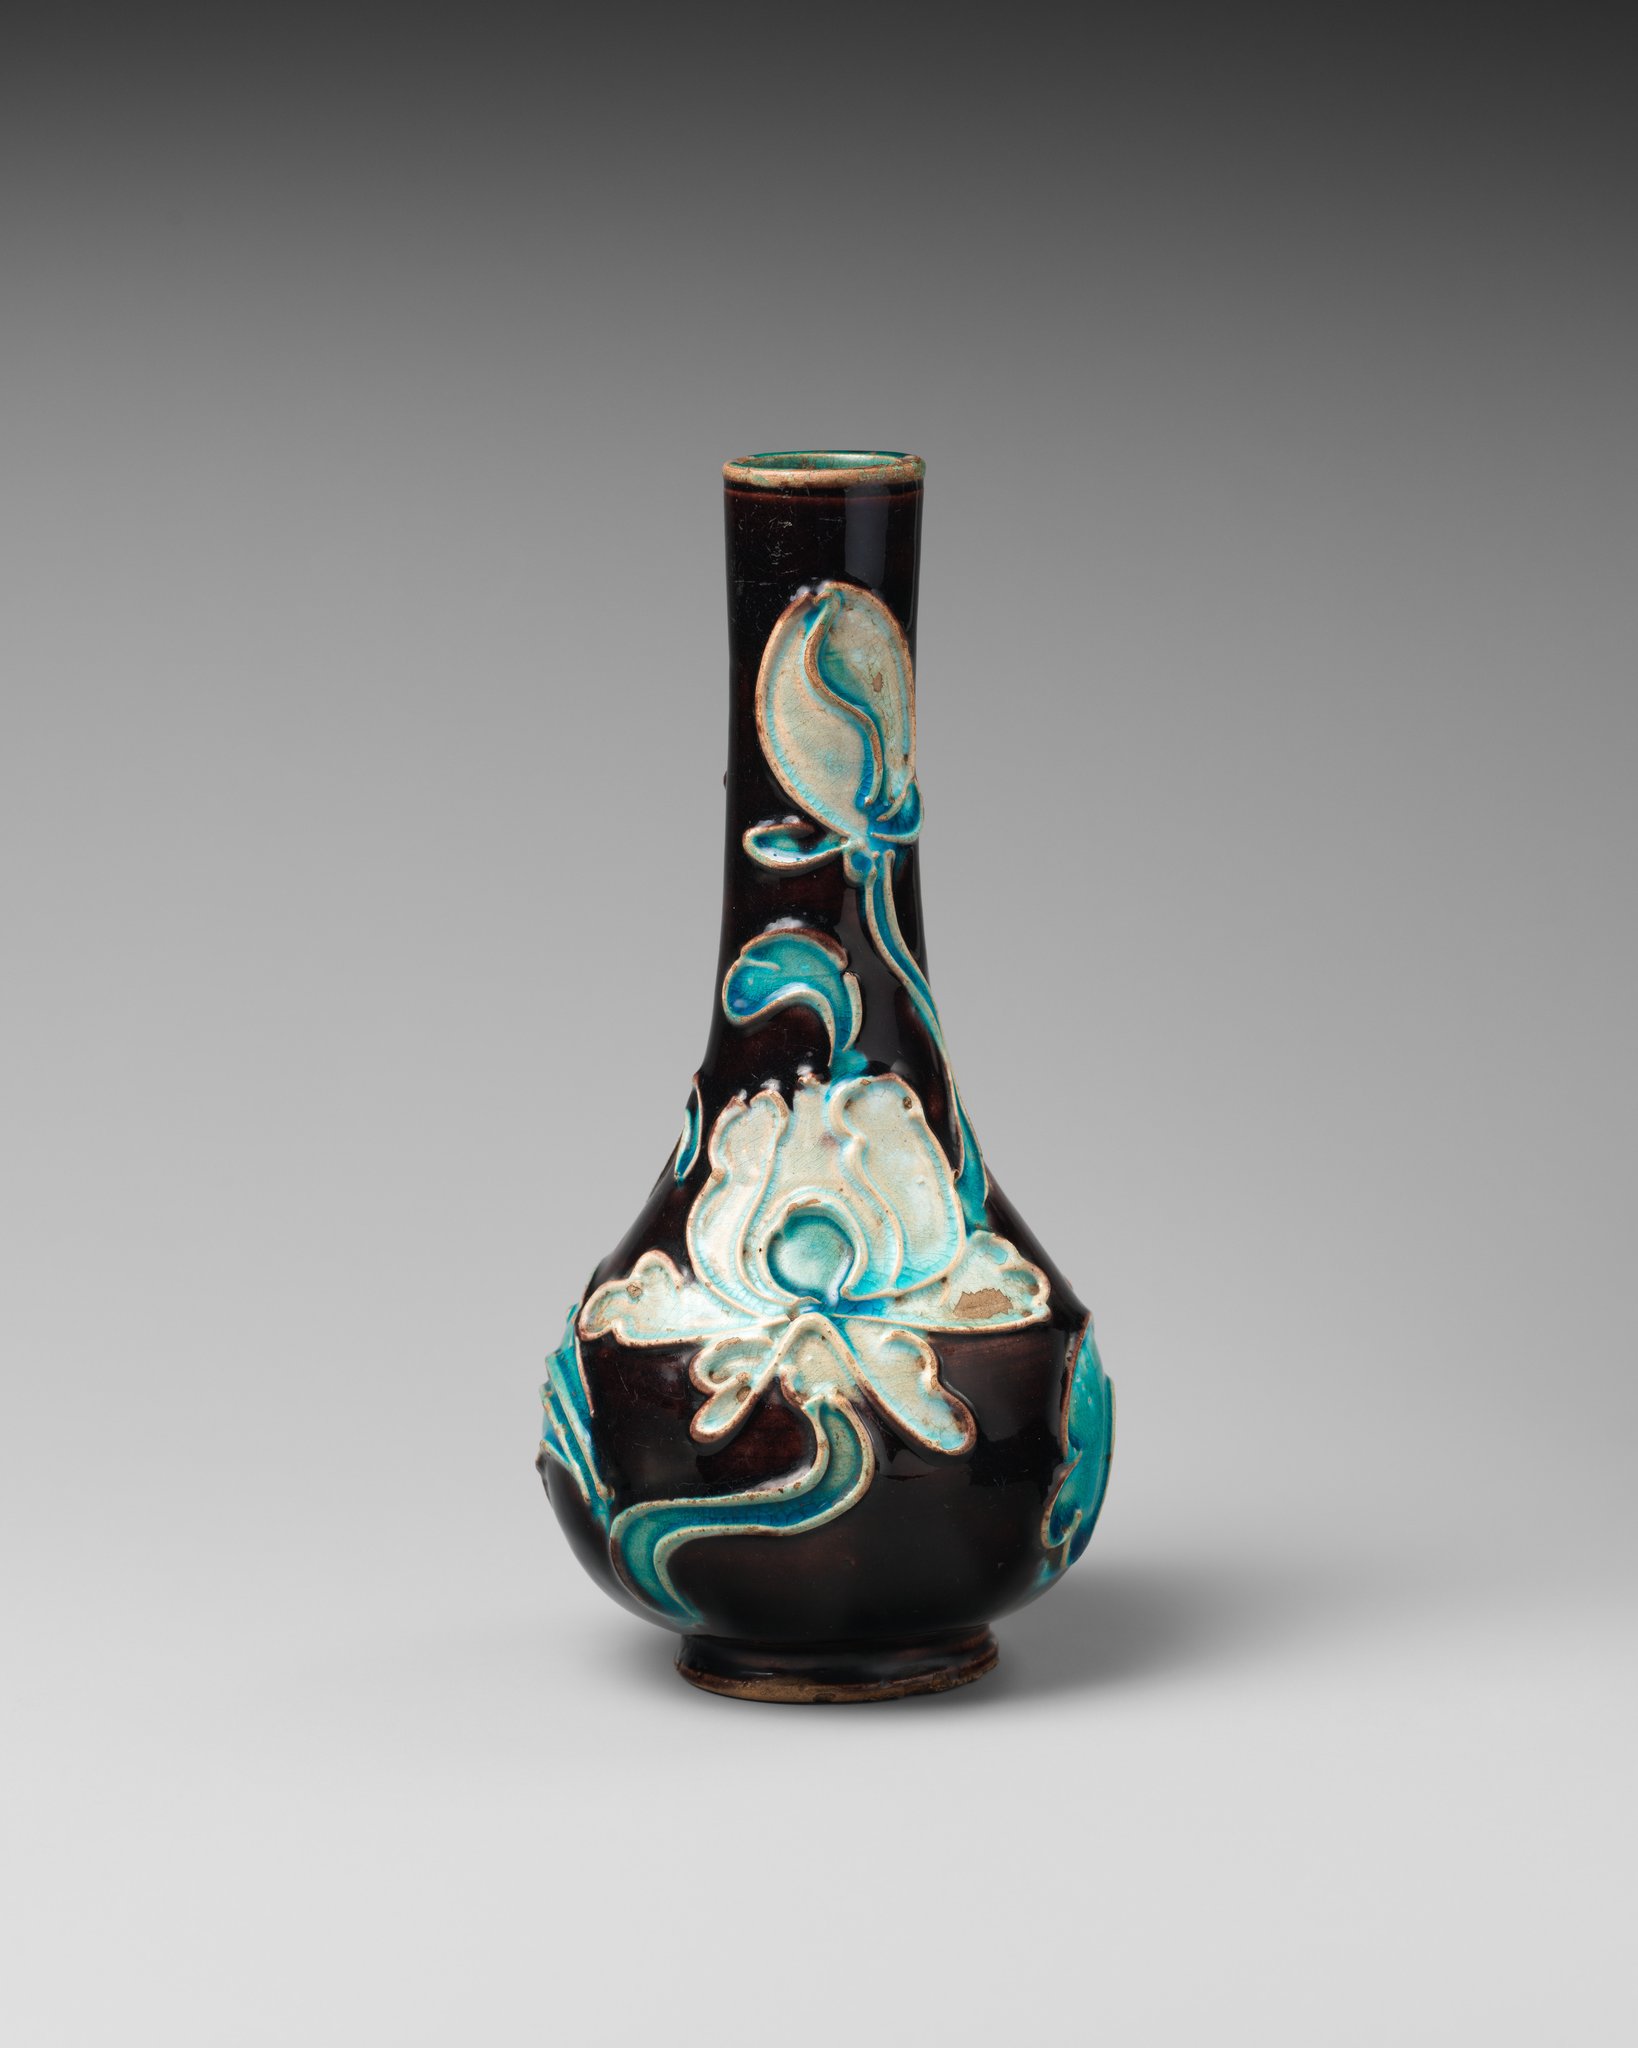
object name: vase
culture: chinese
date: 1501-1600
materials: stoneware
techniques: enamel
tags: flowers